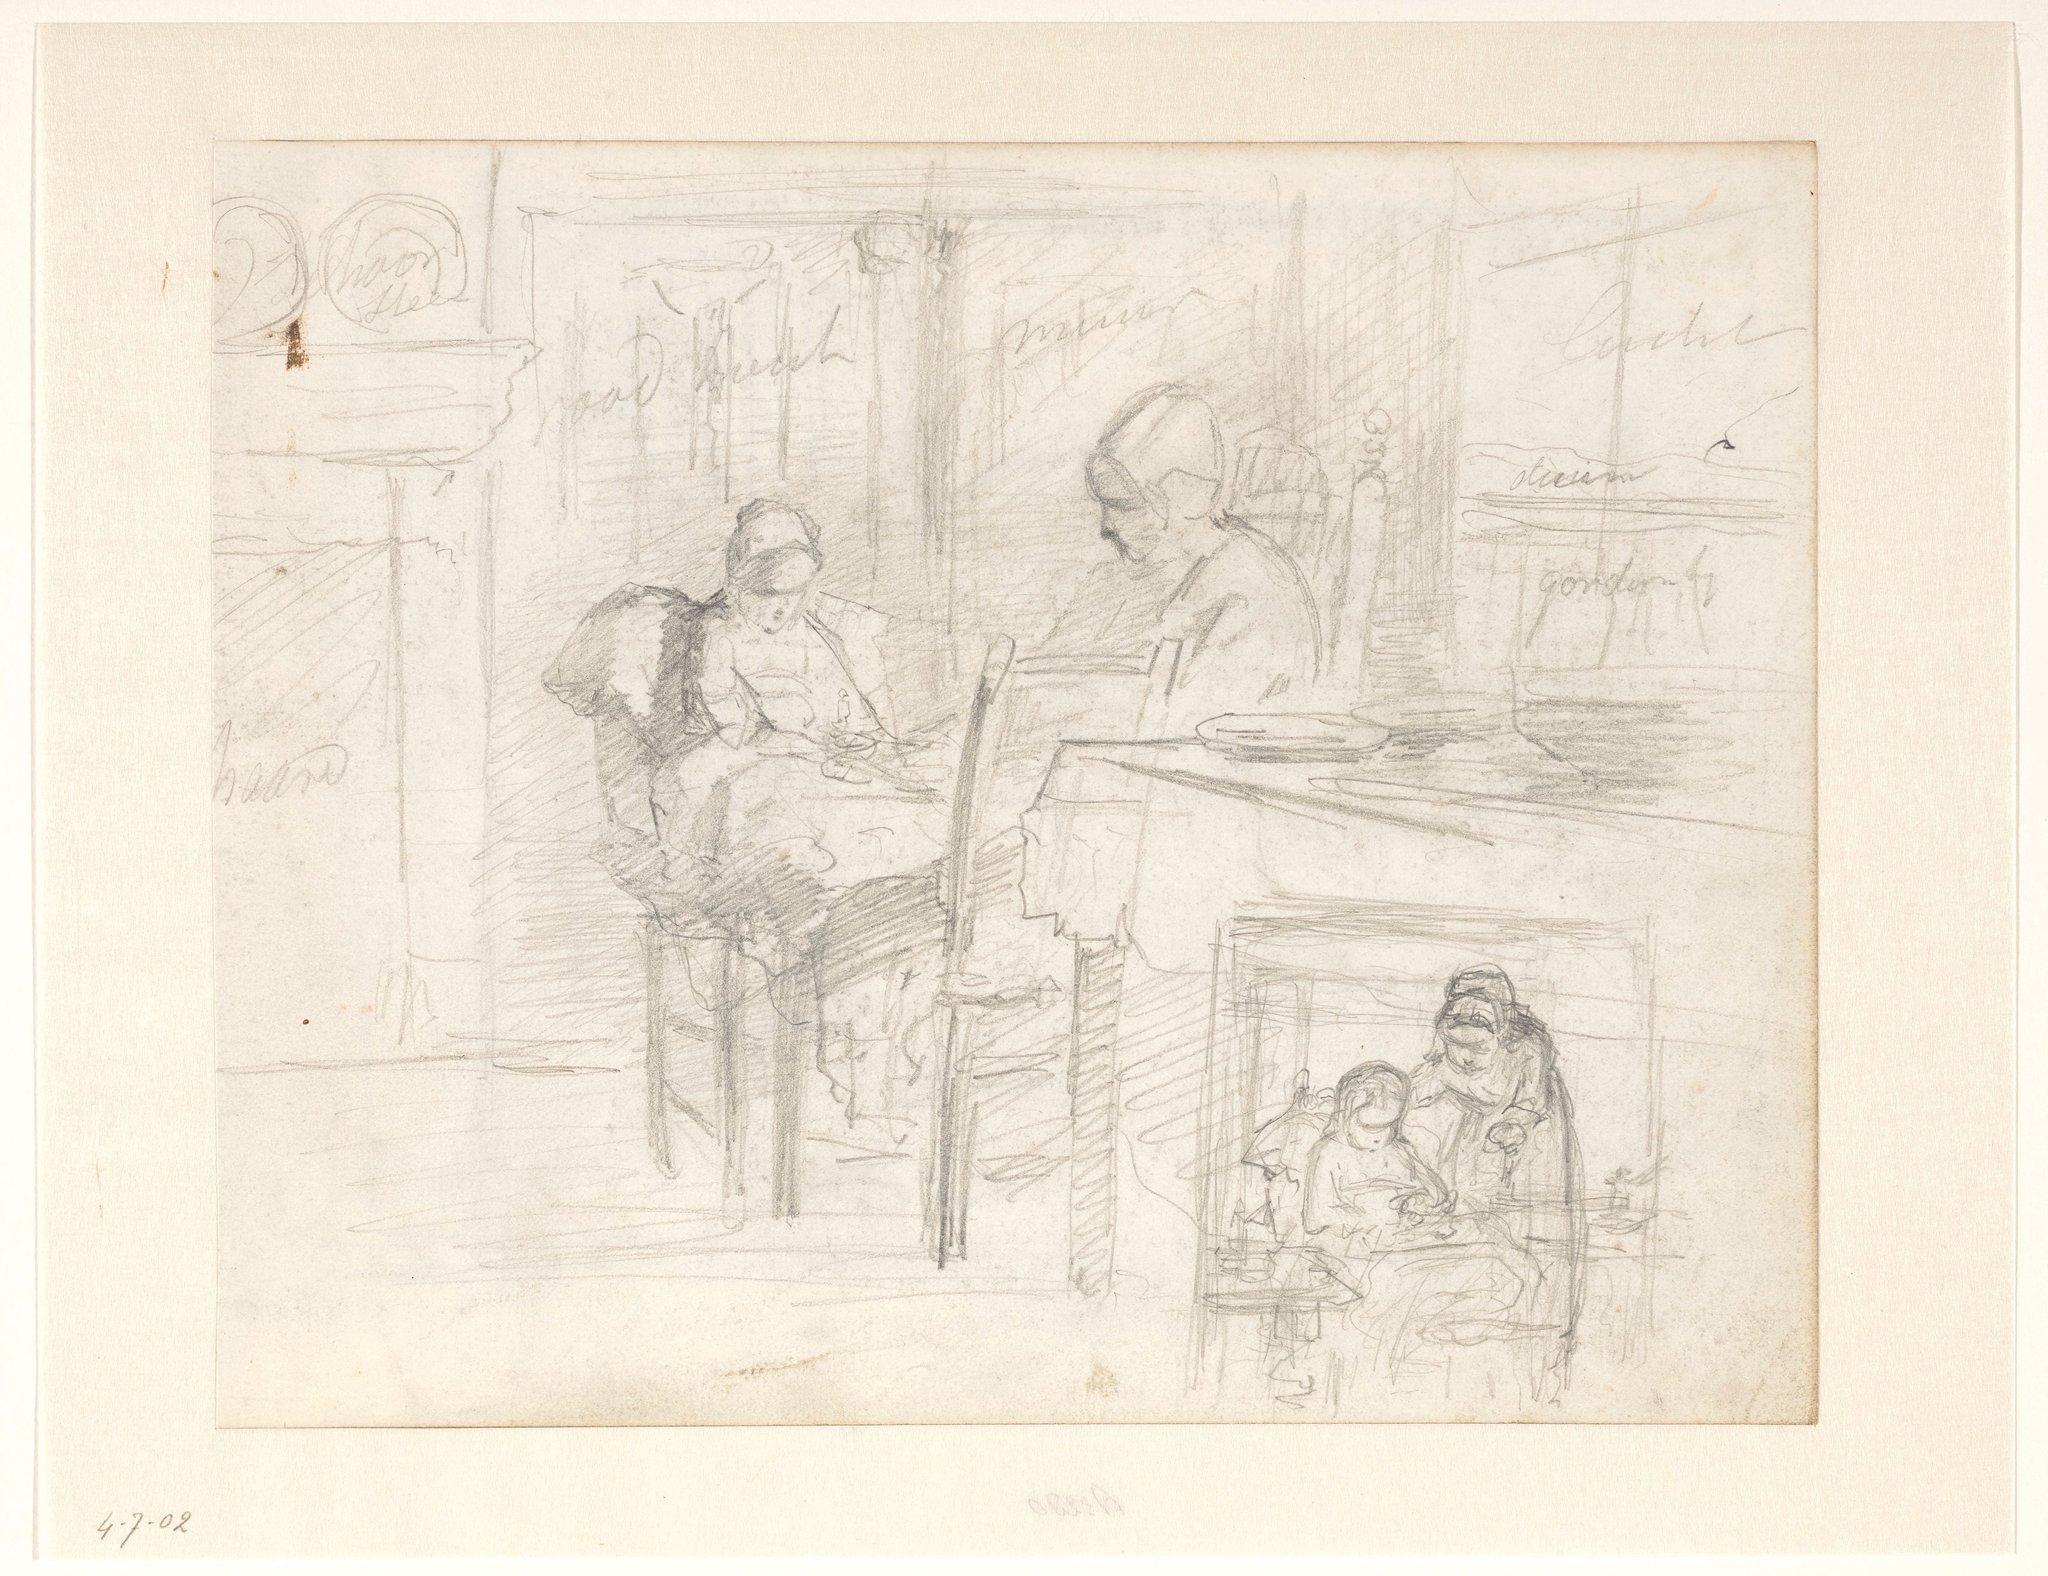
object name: drawing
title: Twee voorstellingen van een moeder met kind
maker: hendrik valkenburg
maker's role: draughtsman, painter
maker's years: 1826-1896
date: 1836-1896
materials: chalk, paper, pencil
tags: interior of the house, mother and child(ren), woman and child(ren) (family group)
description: Twee voorstellingen van een moeder met kind in een interieur. Verso: moeder met twee kinderen.